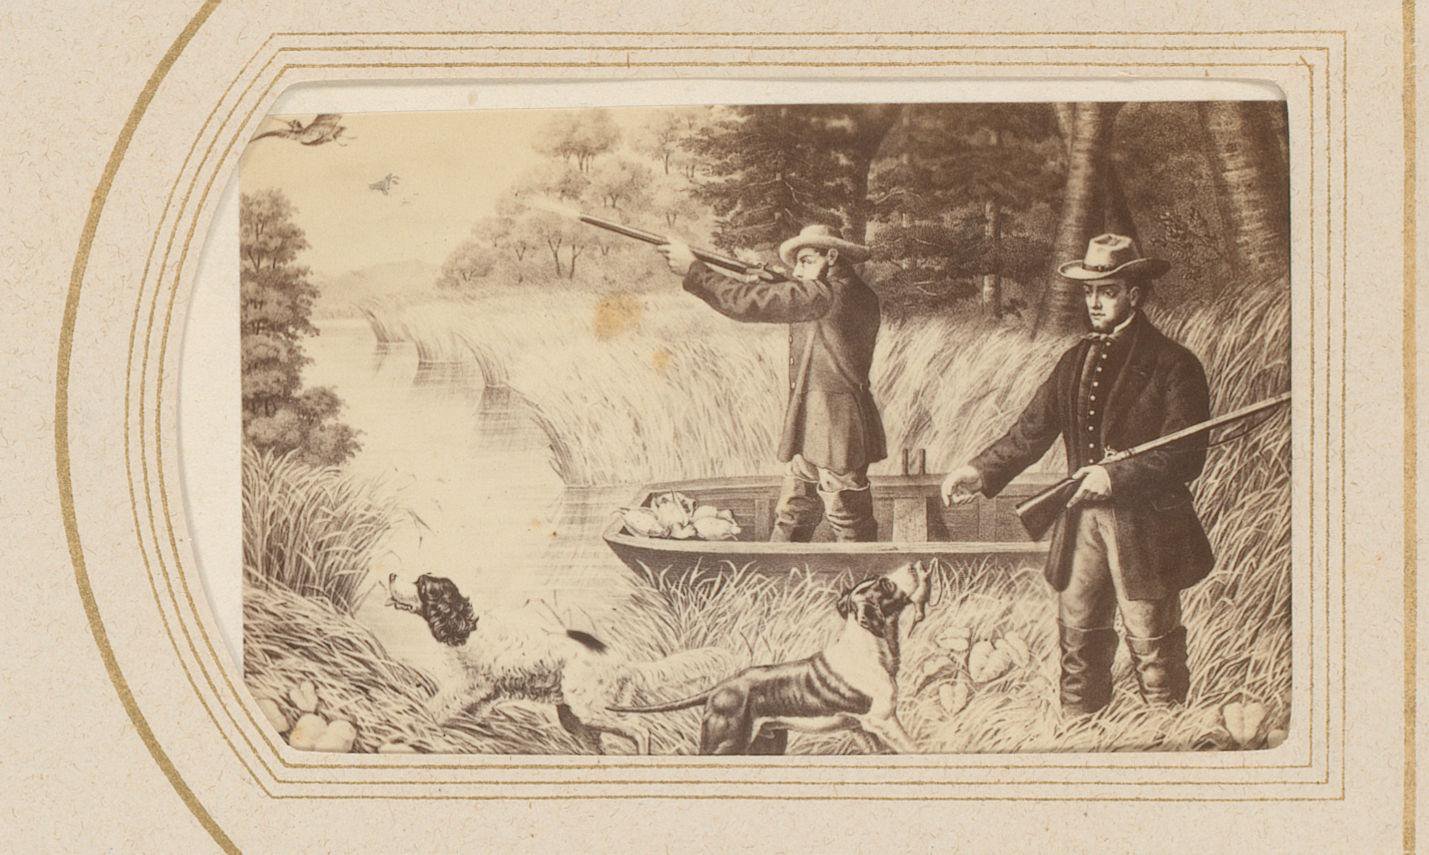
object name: carte de visite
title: Fotoreproductie van La chasse au pointe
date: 1870-1900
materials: cardboard, photographic support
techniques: albumen print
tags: hunting, chase, dog, painting, drawing and the graphic arts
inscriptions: annotation: ‘[...]’, inscription: ‘Collier/ La chasse au pointe/ [...]/ Snout’